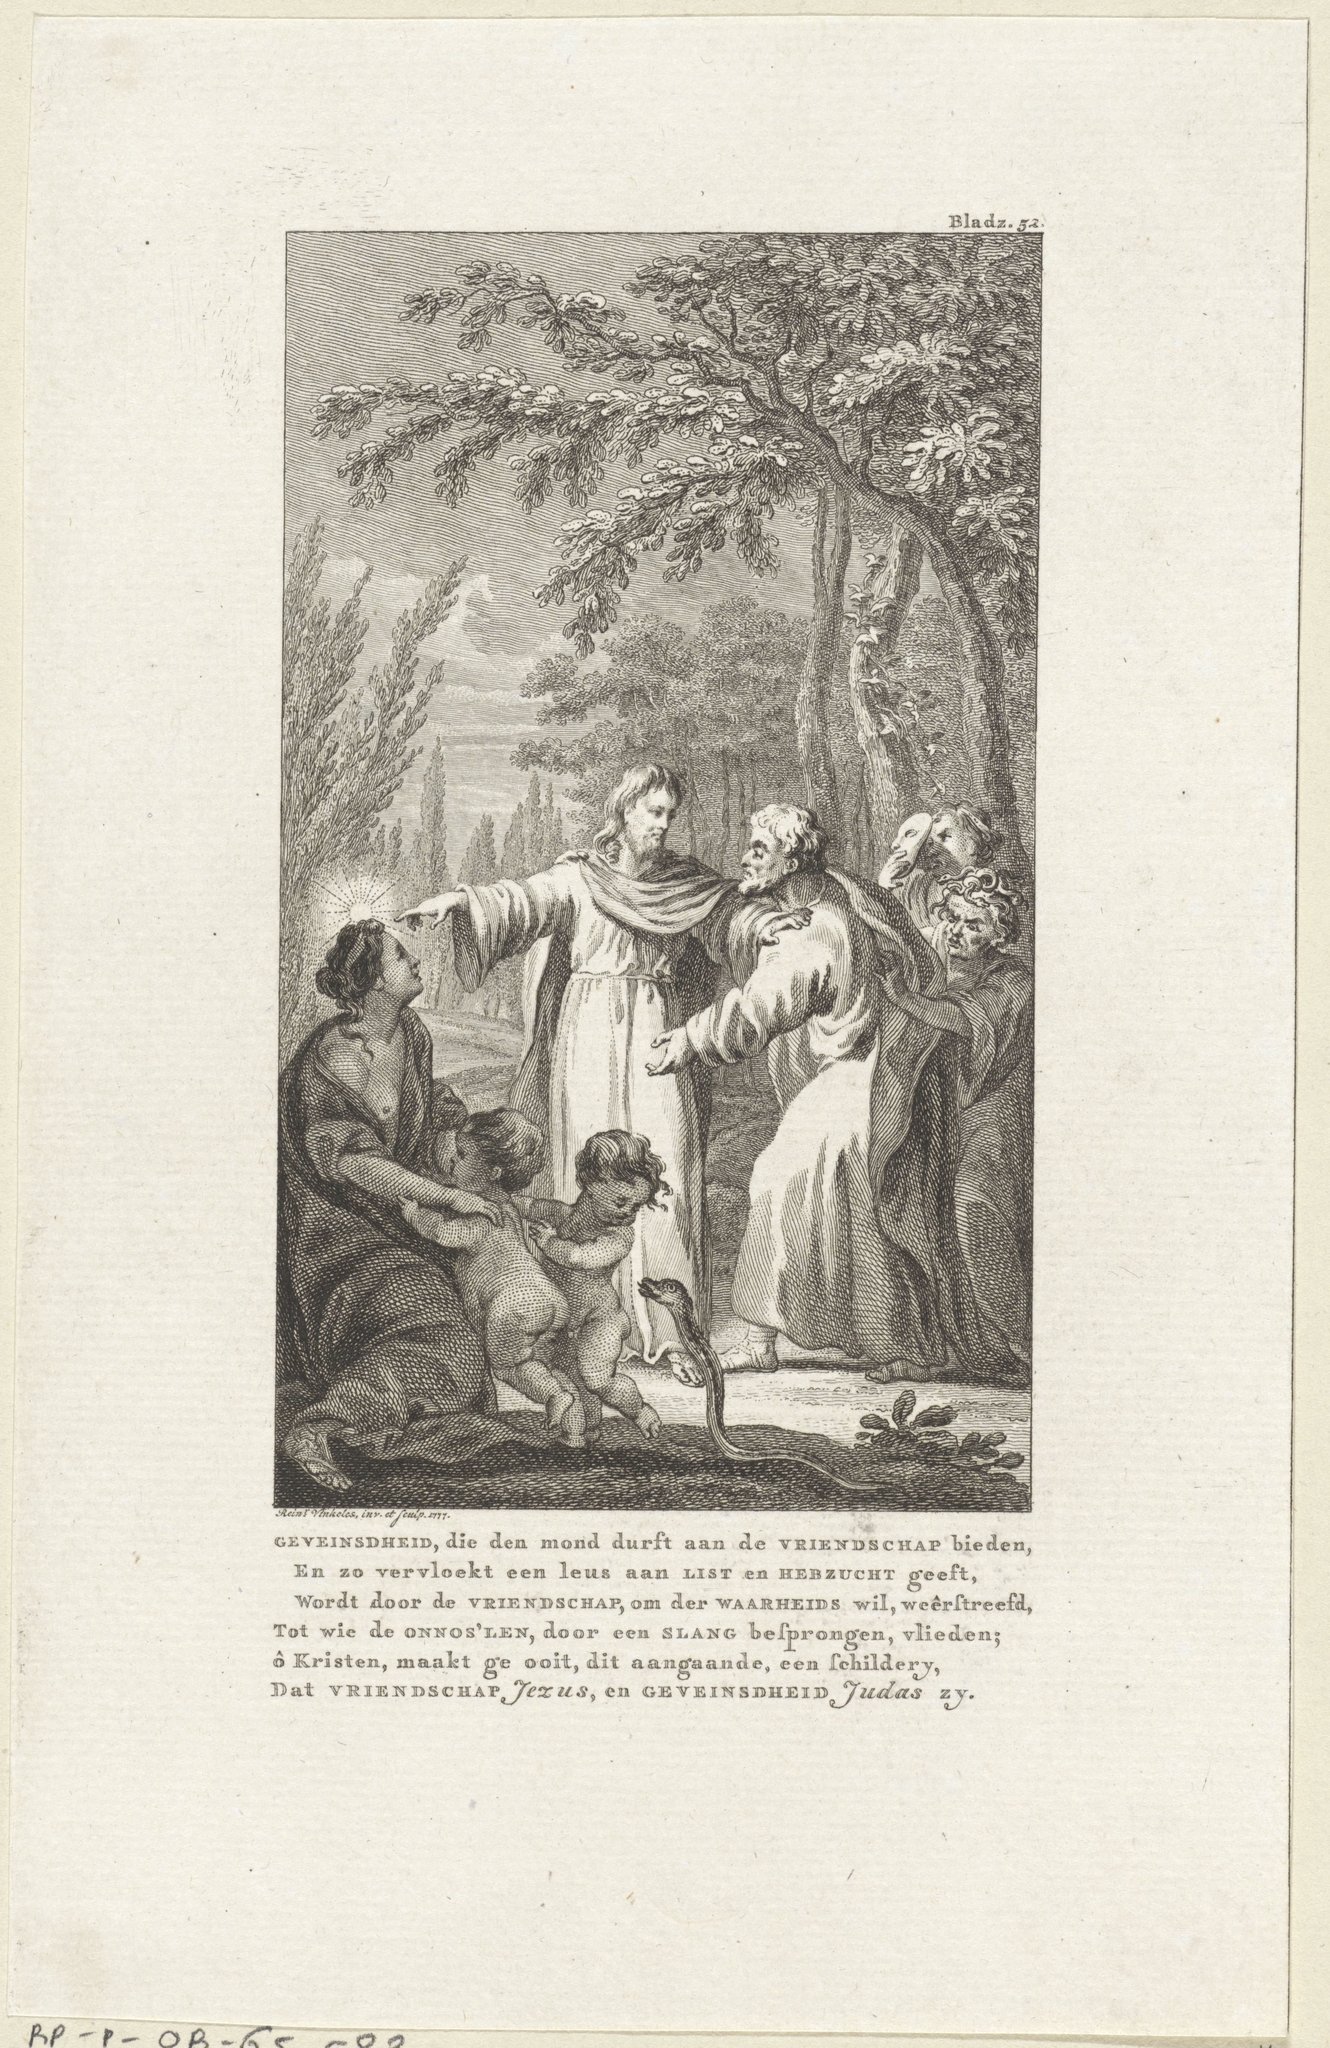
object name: print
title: Allegorie met Christus als Vriendschap en Judas als Bedrog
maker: reinier vinkeles (i)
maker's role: draughtsman, print maker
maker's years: 1741-1816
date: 1777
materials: paper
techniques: engraving, etching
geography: amsterdam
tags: 'tradimento' (ripa), christ, friendship; 'amicitia' (ripa), judas iscariot (not in biblical context)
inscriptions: collector's mark: Lugt 240